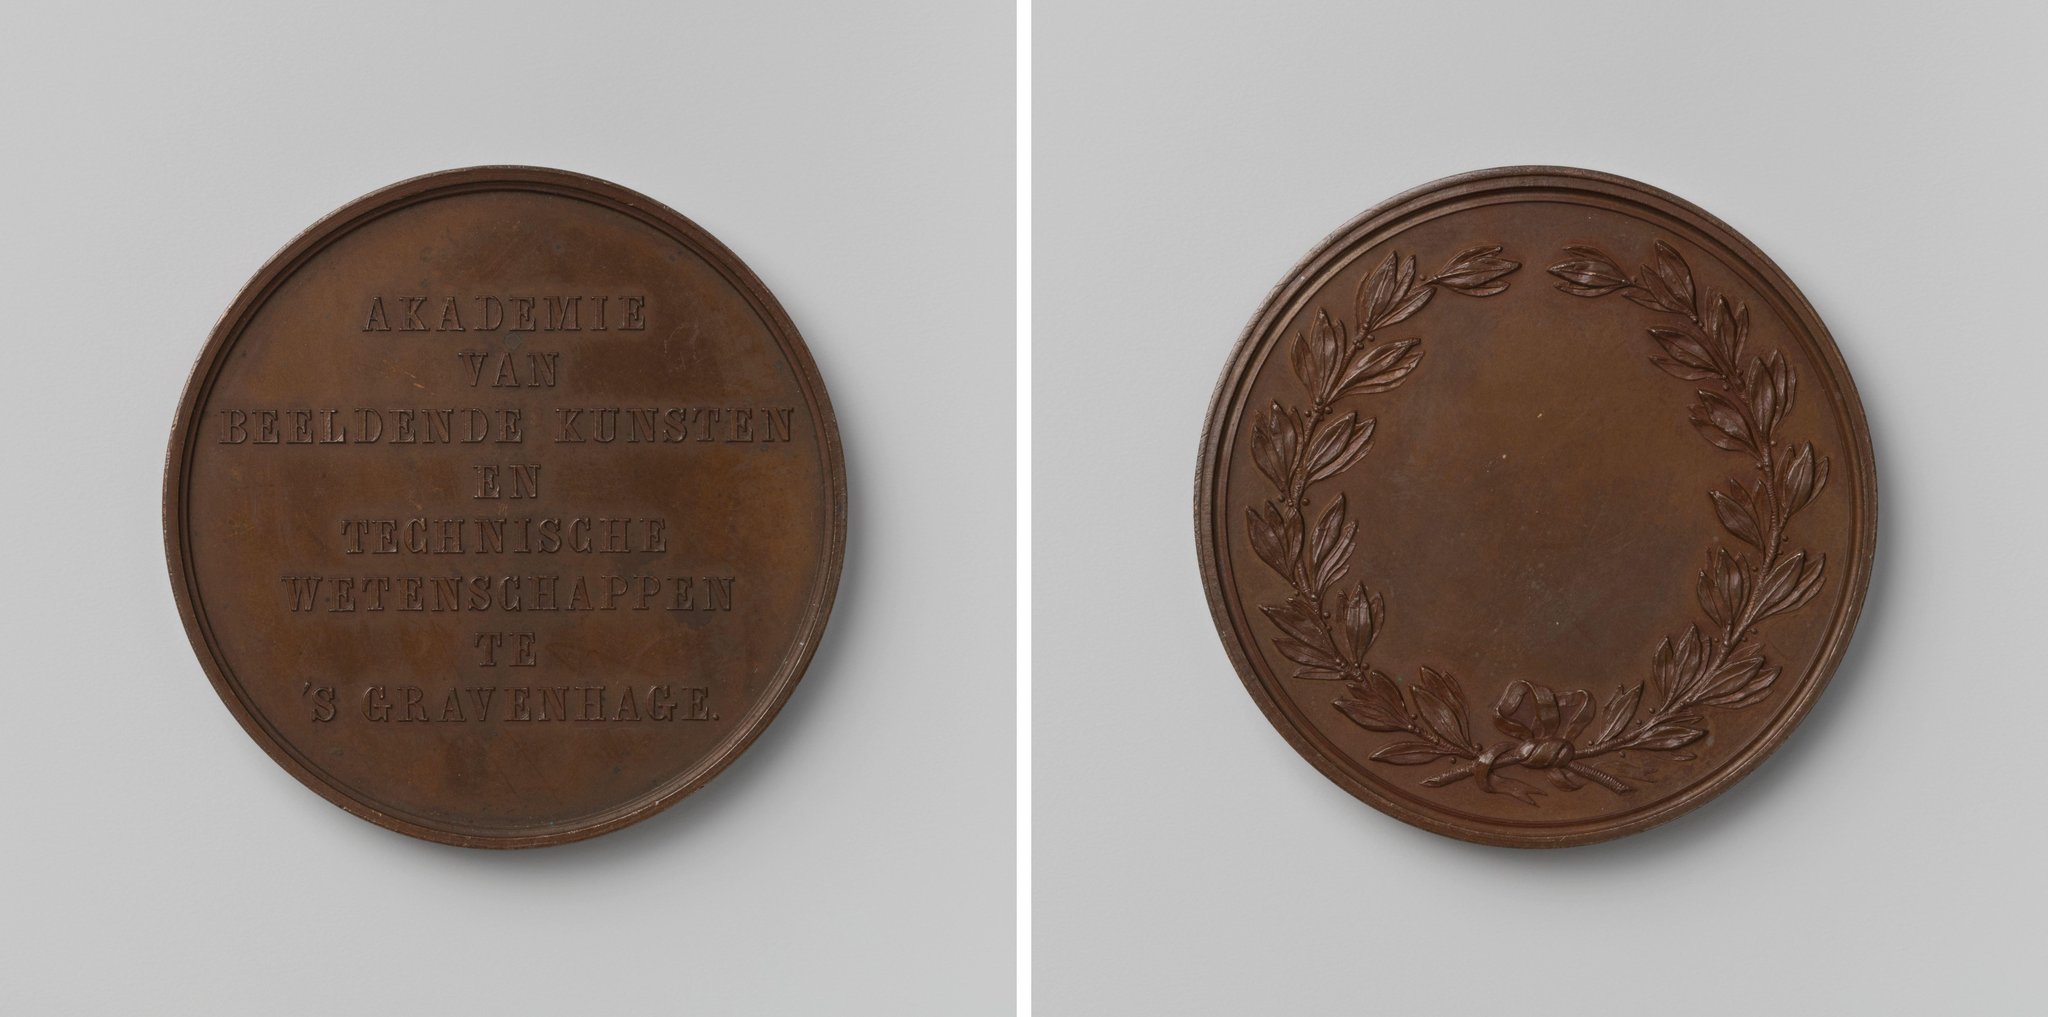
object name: medal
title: Akademie van Beeldende Kunsten en Technische Wetenschappen te 's-Gravenhage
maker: Anonymous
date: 1873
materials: bronze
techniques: striking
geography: utrecht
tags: the hague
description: Bronzen penning. Voorzijde: opschrift. Keerzijde: blanco veld binnen lauwerkrans